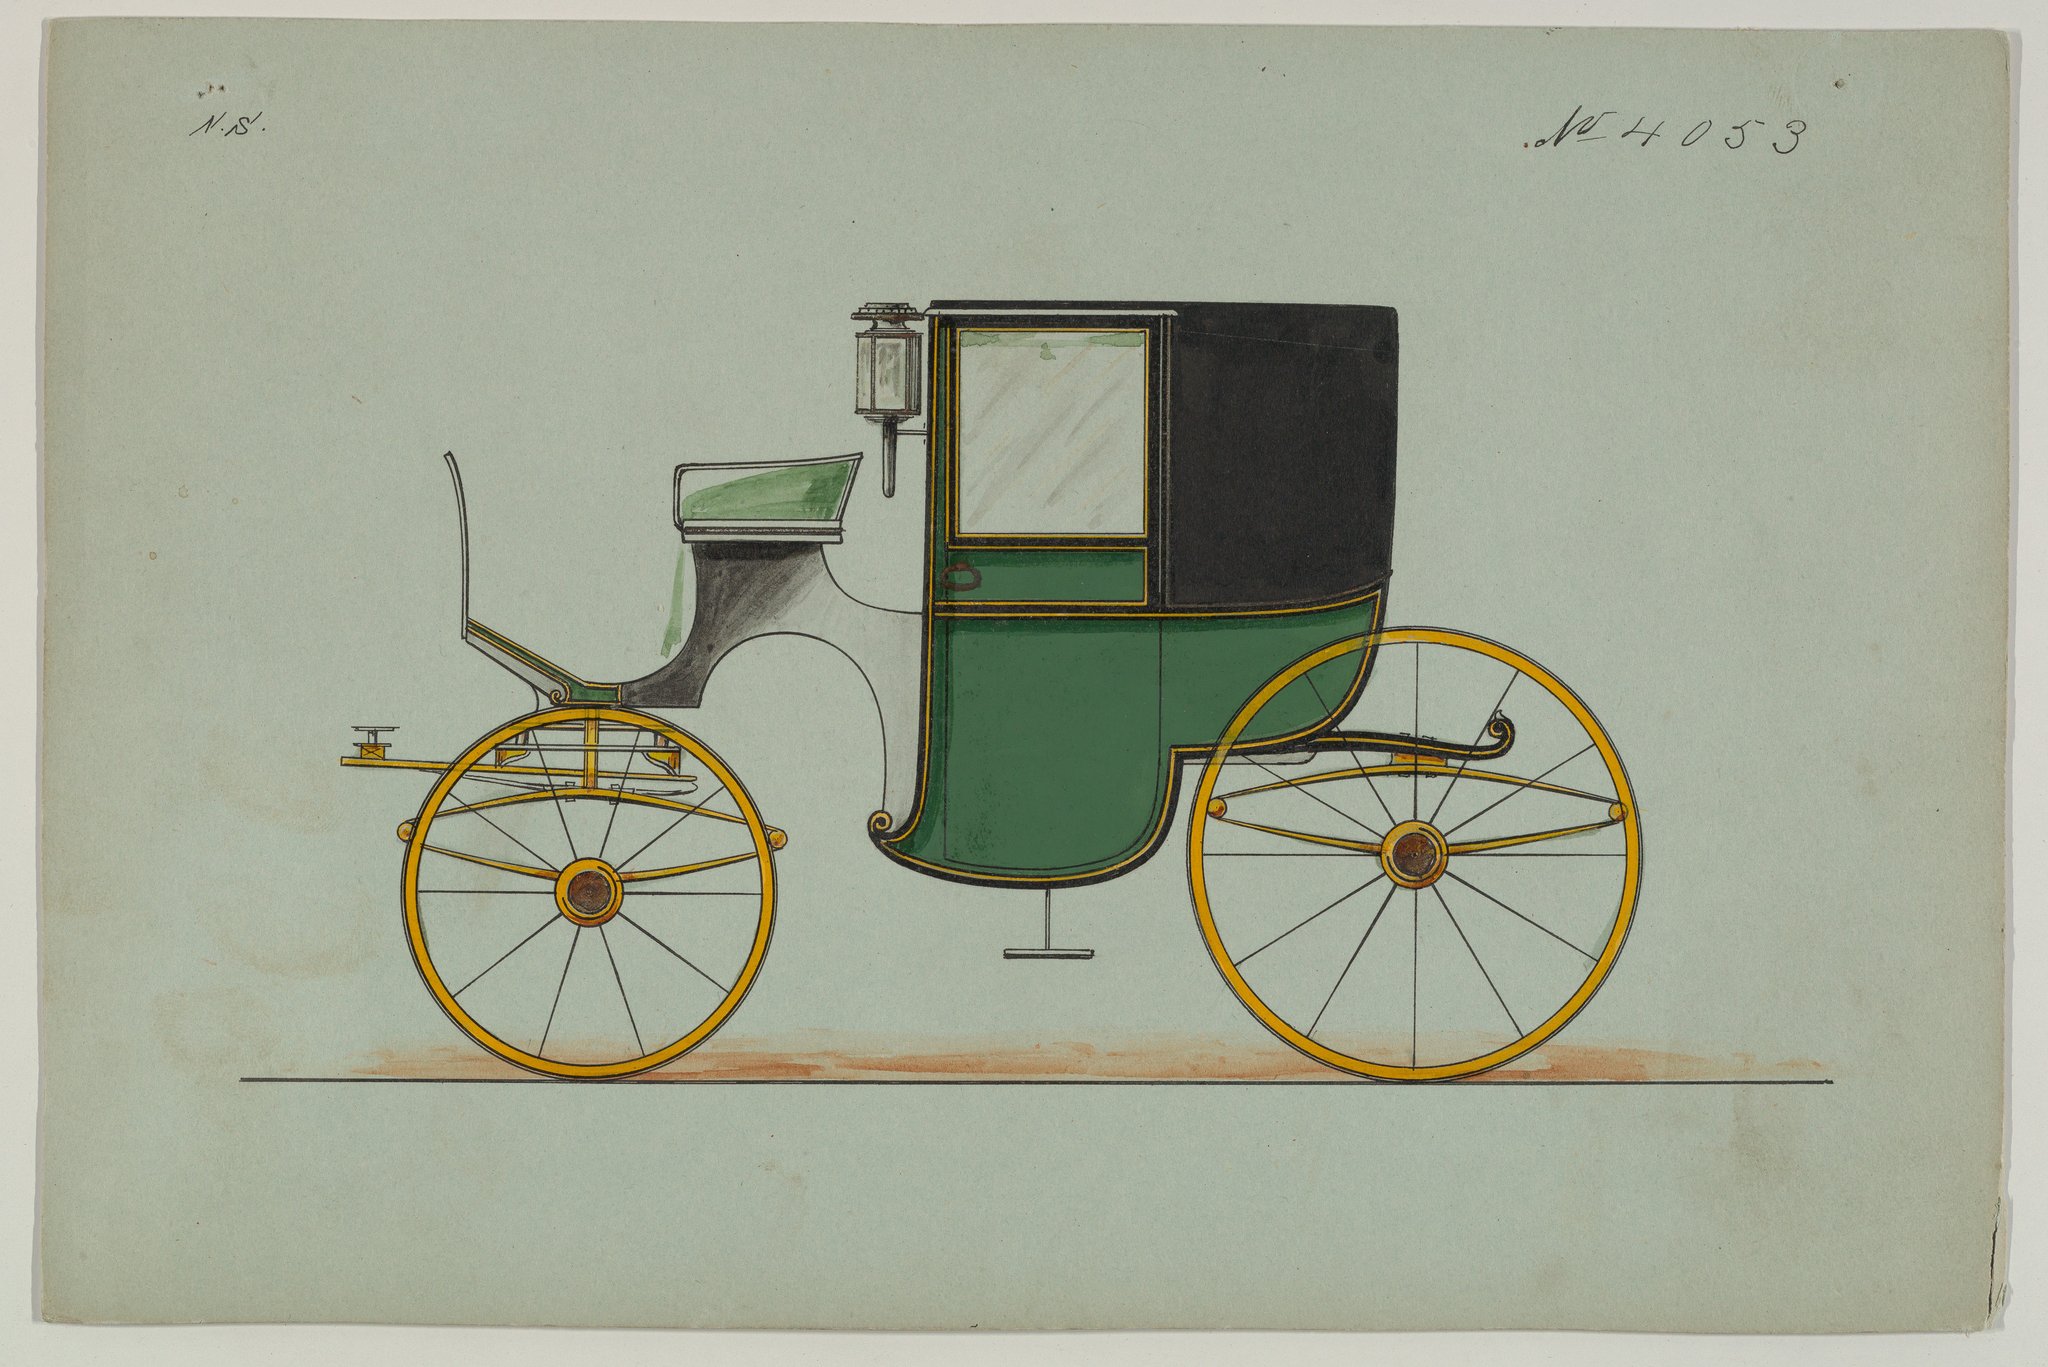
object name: drawing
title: Brougham #4053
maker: brewster & co.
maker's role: manufacturer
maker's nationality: american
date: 1889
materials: ink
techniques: pen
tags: carriages